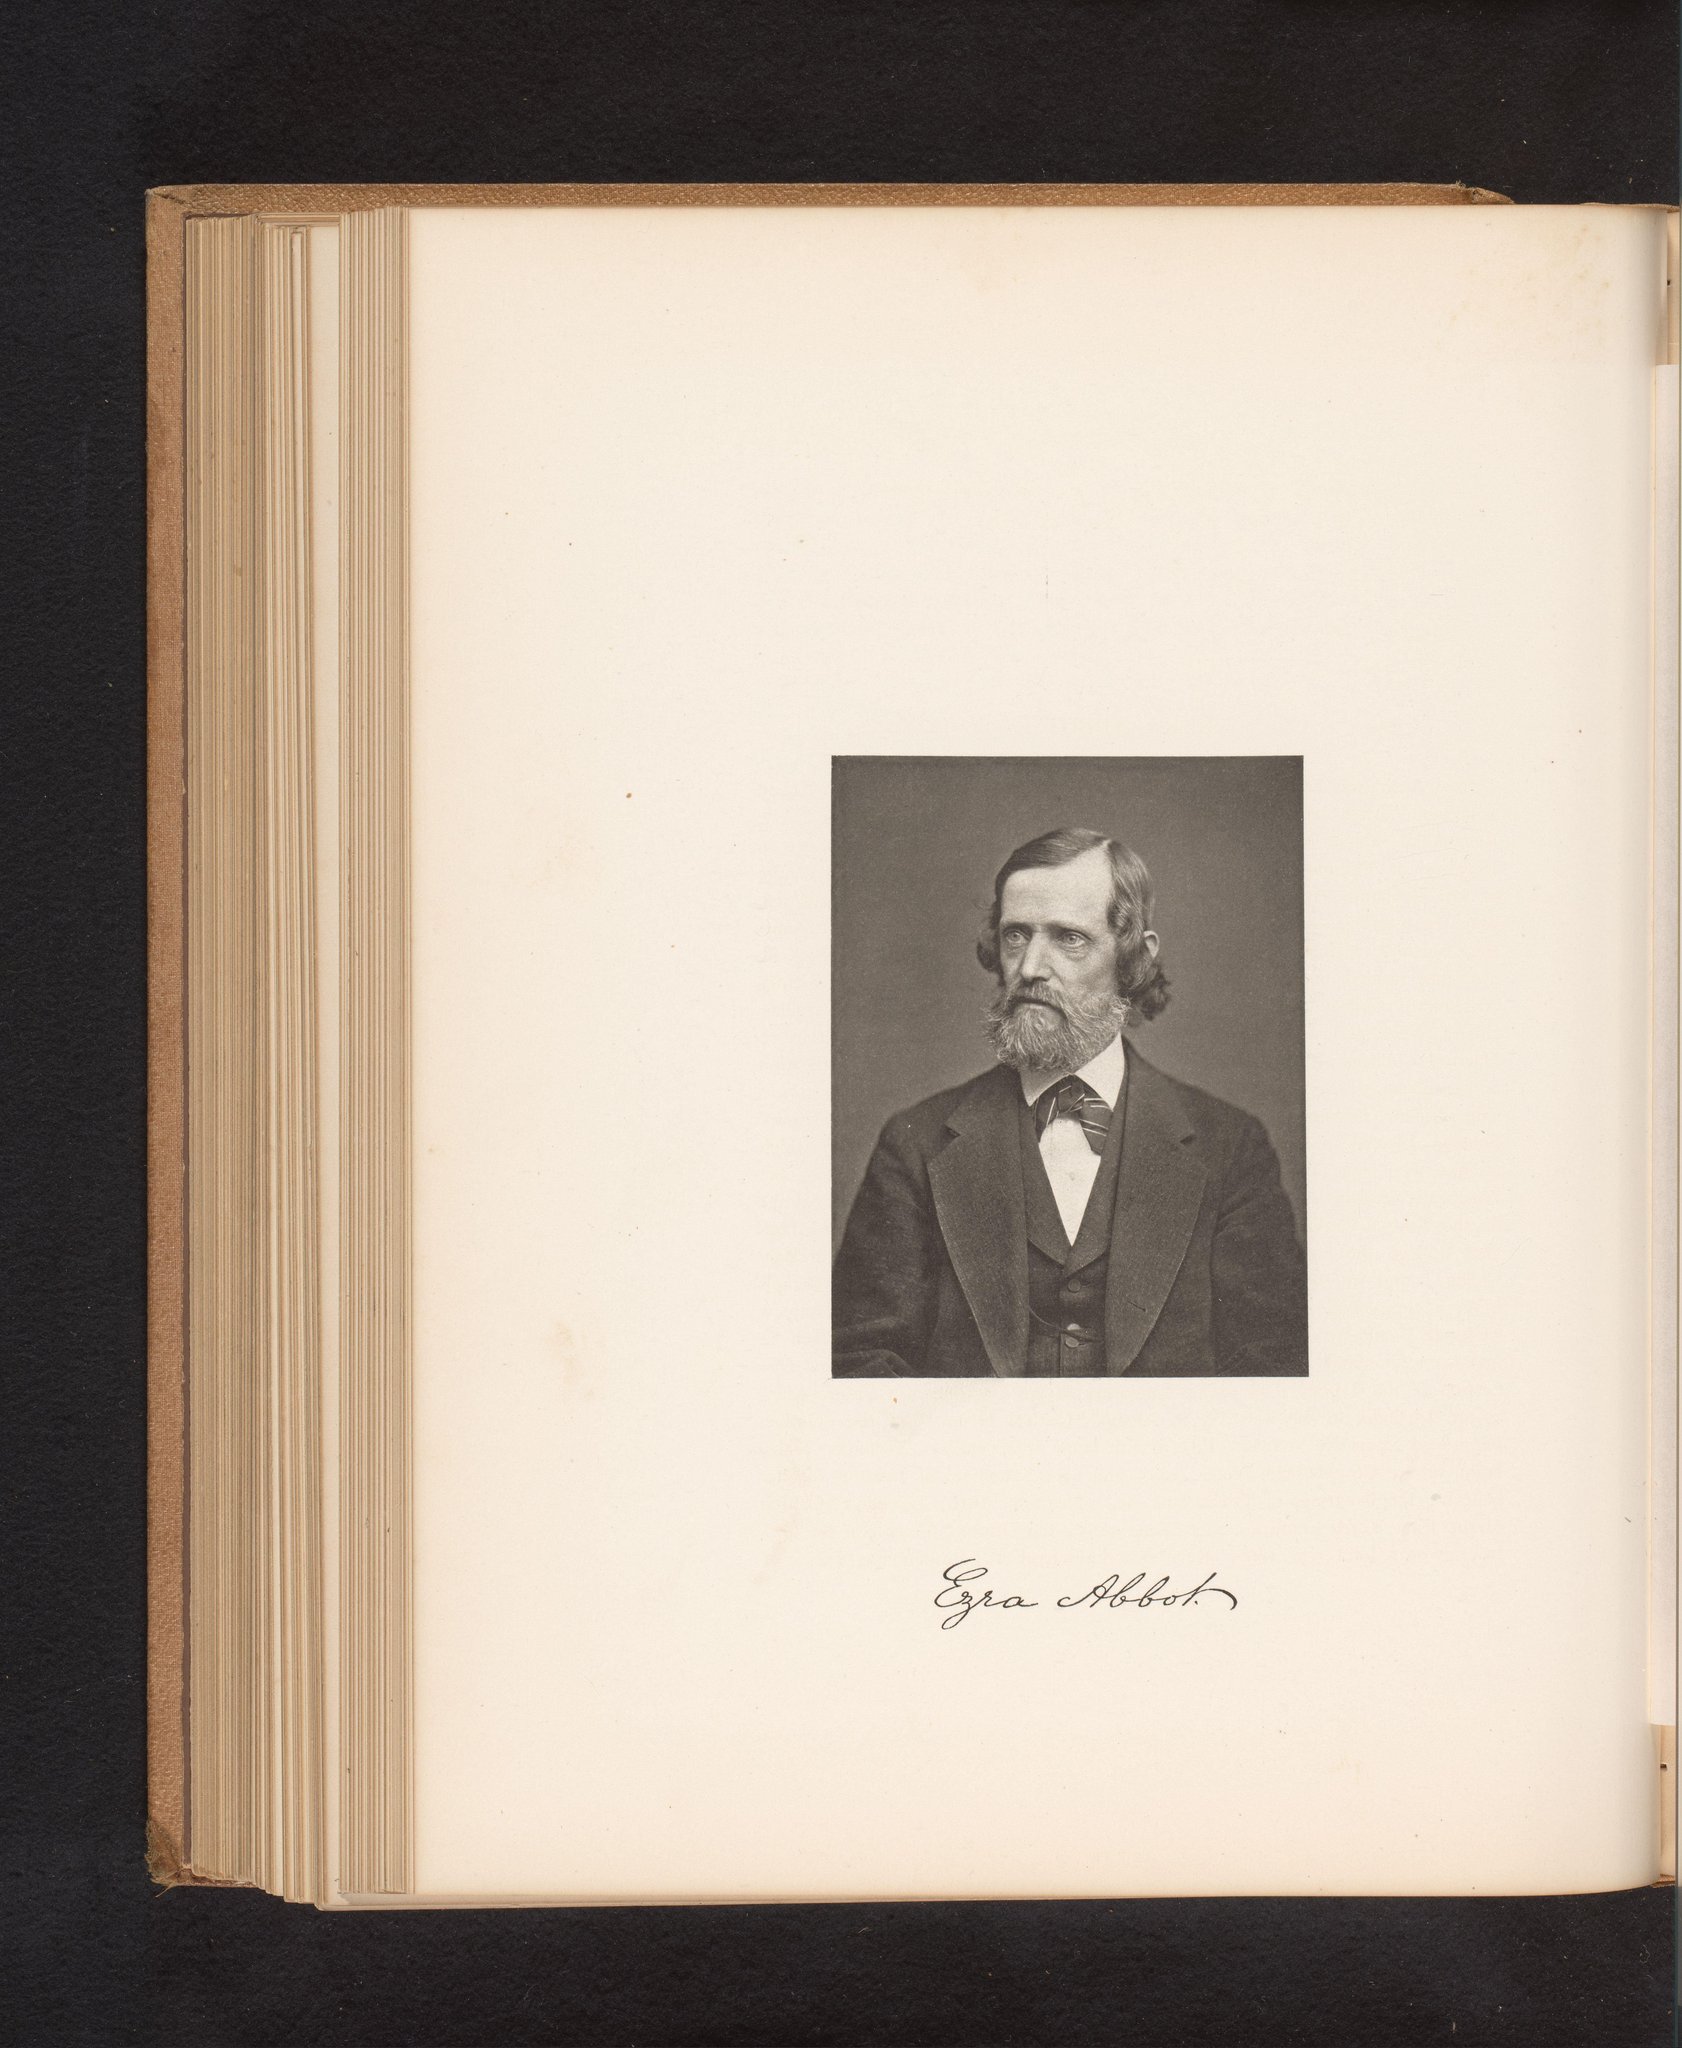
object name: page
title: Ezra Abbot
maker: Anonymous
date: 1870-1875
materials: paper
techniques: photograph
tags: historical persons, writer, poet, author